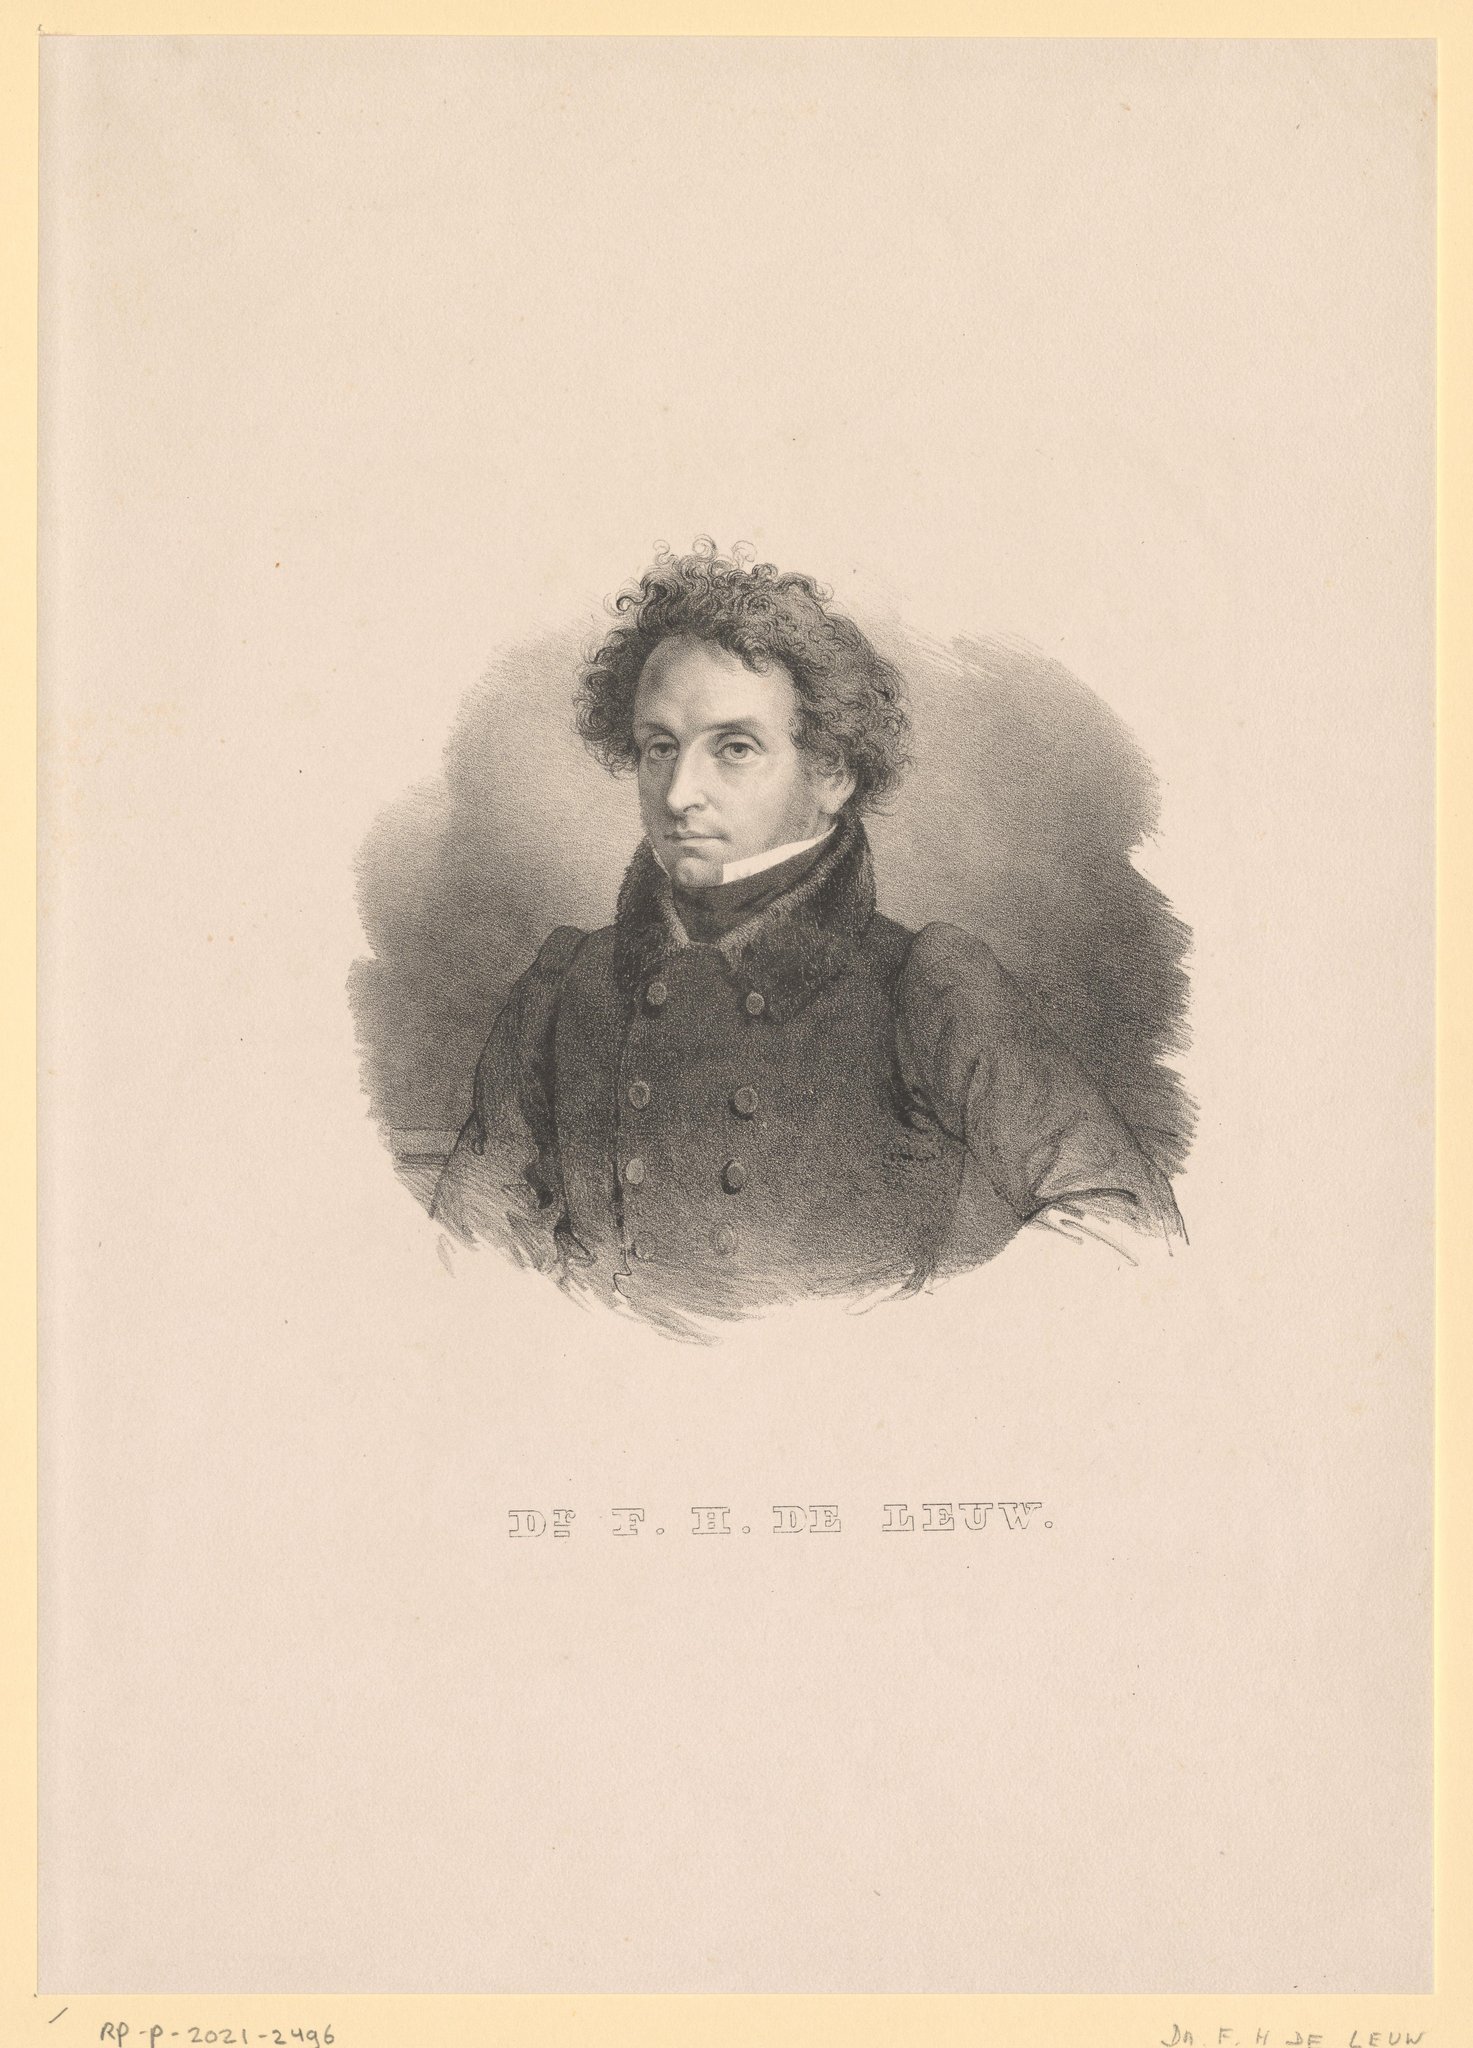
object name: print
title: Portret van Friedrich Hermann de Leuw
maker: Anonymous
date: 1823-1861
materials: paper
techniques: lithograph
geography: germany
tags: historical persons, physician, doctor (+ portrait of scholar, scientist)